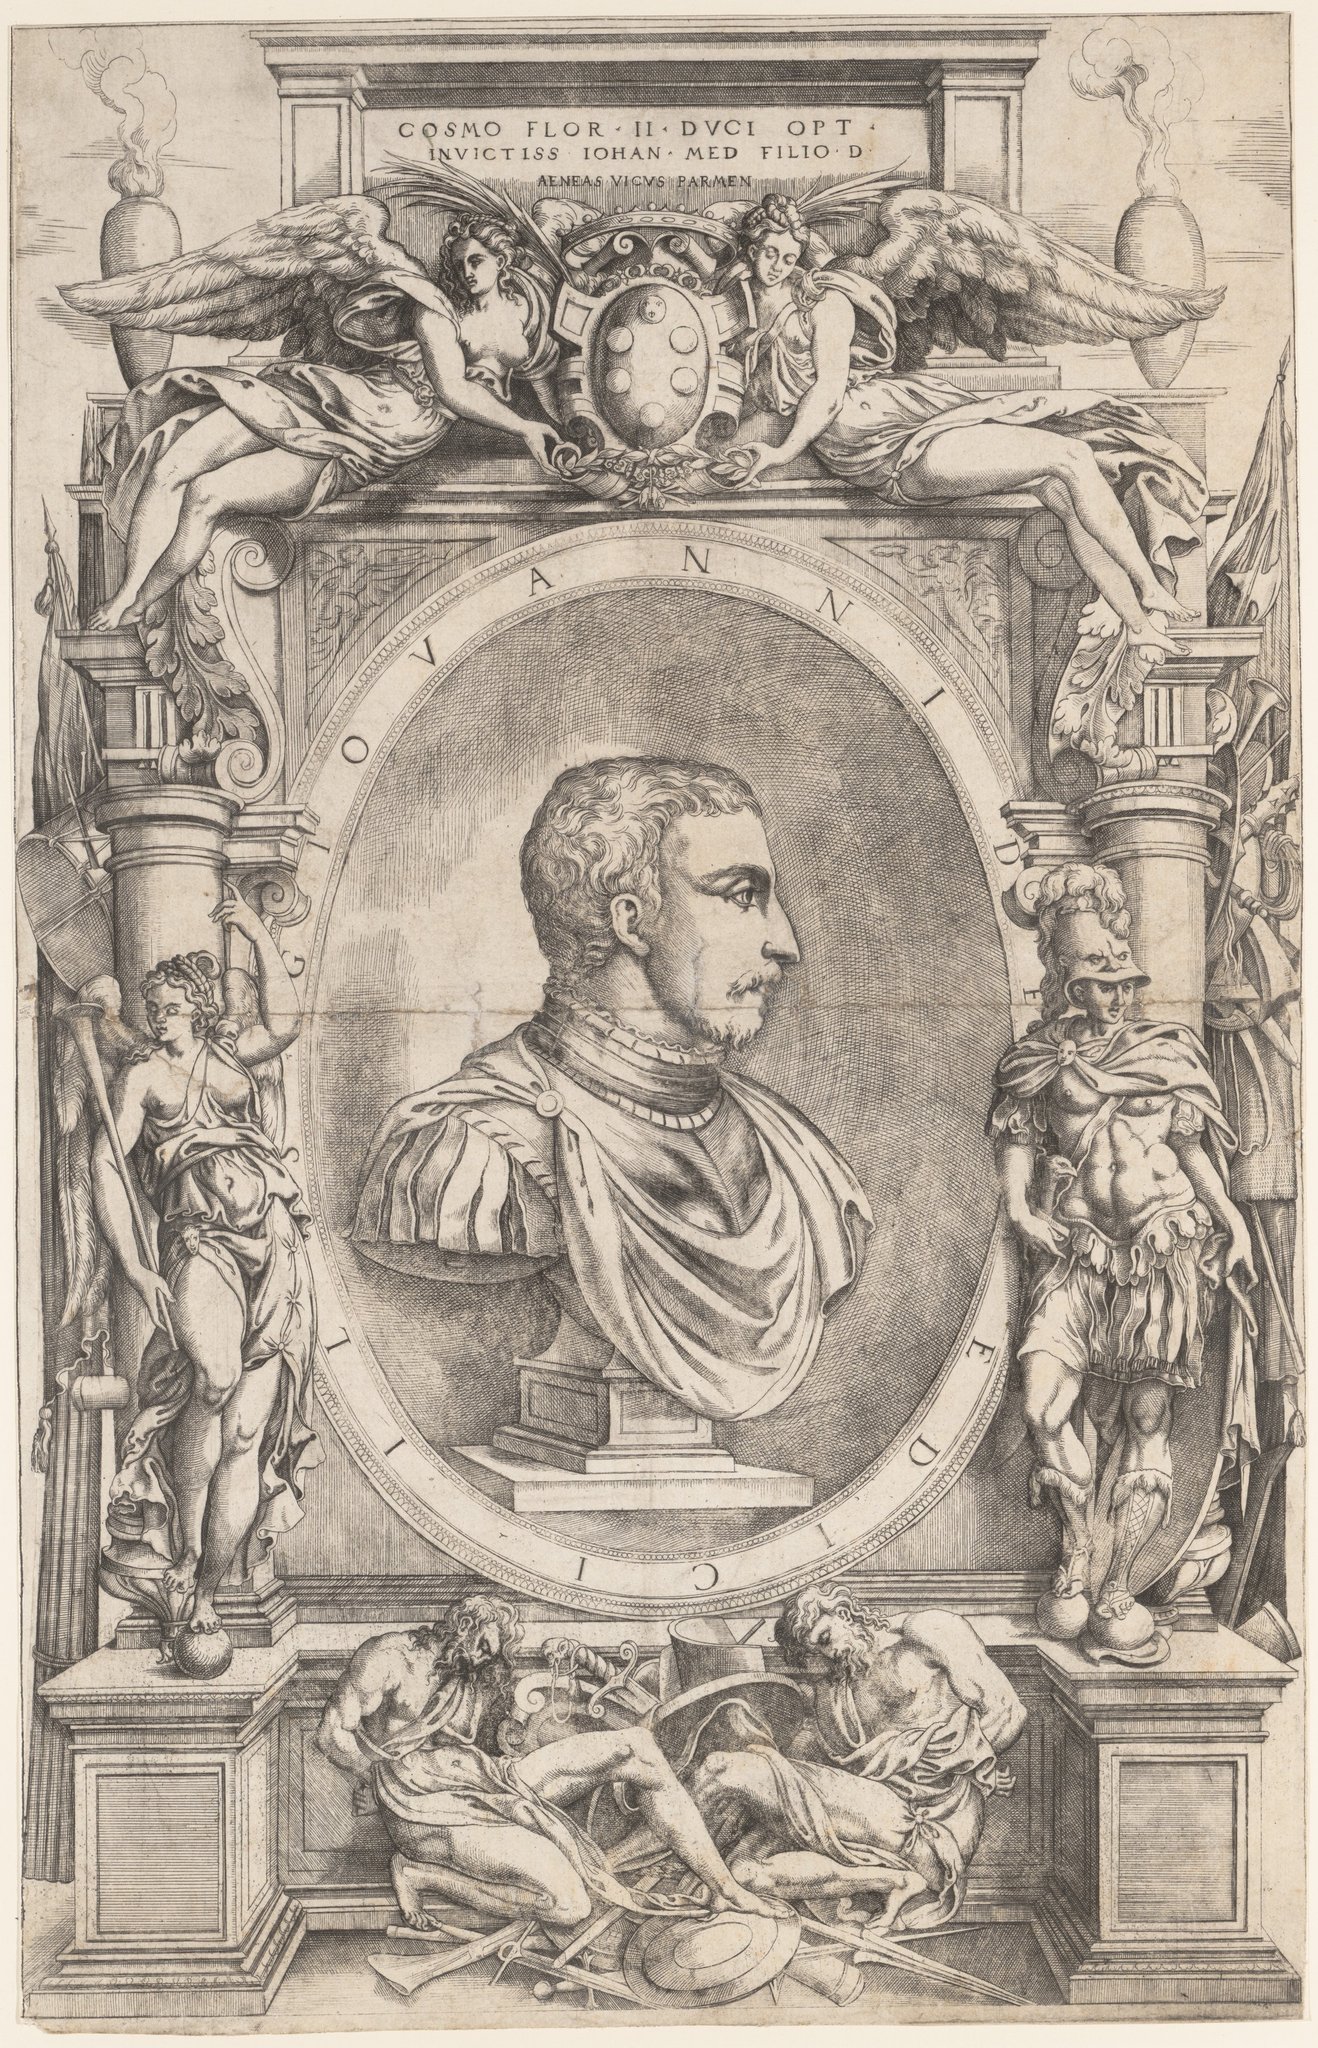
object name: print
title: Giovanni de' Medici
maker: anonymous, italian, 16th century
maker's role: artist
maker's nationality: italian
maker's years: 1500-1600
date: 1550-1600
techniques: engraving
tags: soldiers,men,profiles,women